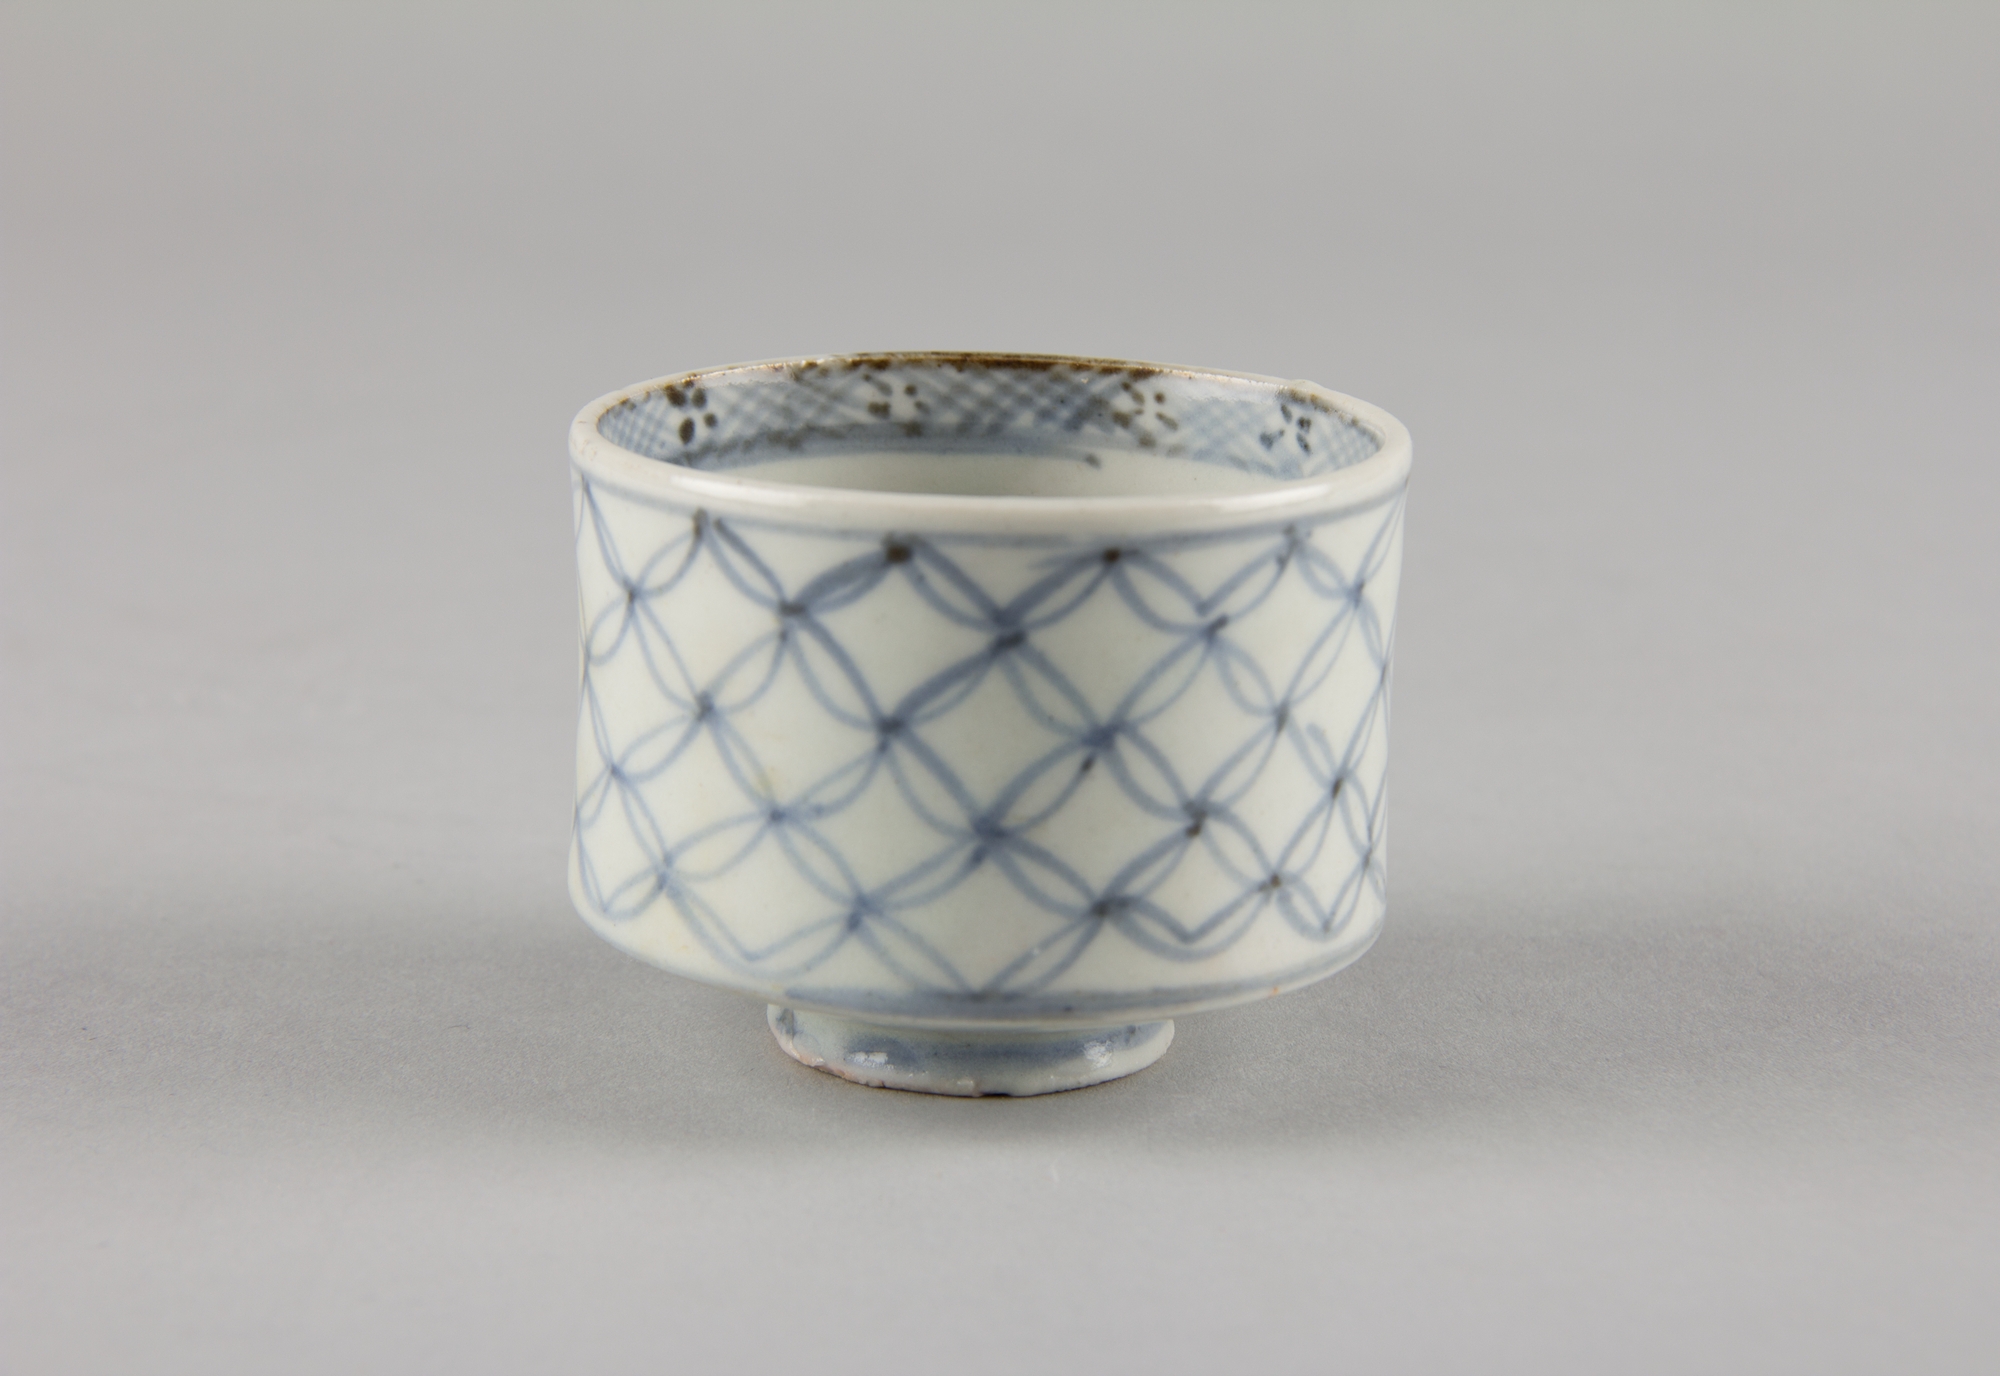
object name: soba cup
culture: japanese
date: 1700-1750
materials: porcelain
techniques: underglaze